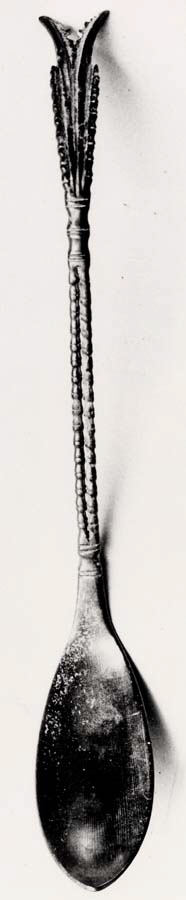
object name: spoon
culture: korean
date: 918-1392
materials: bronze